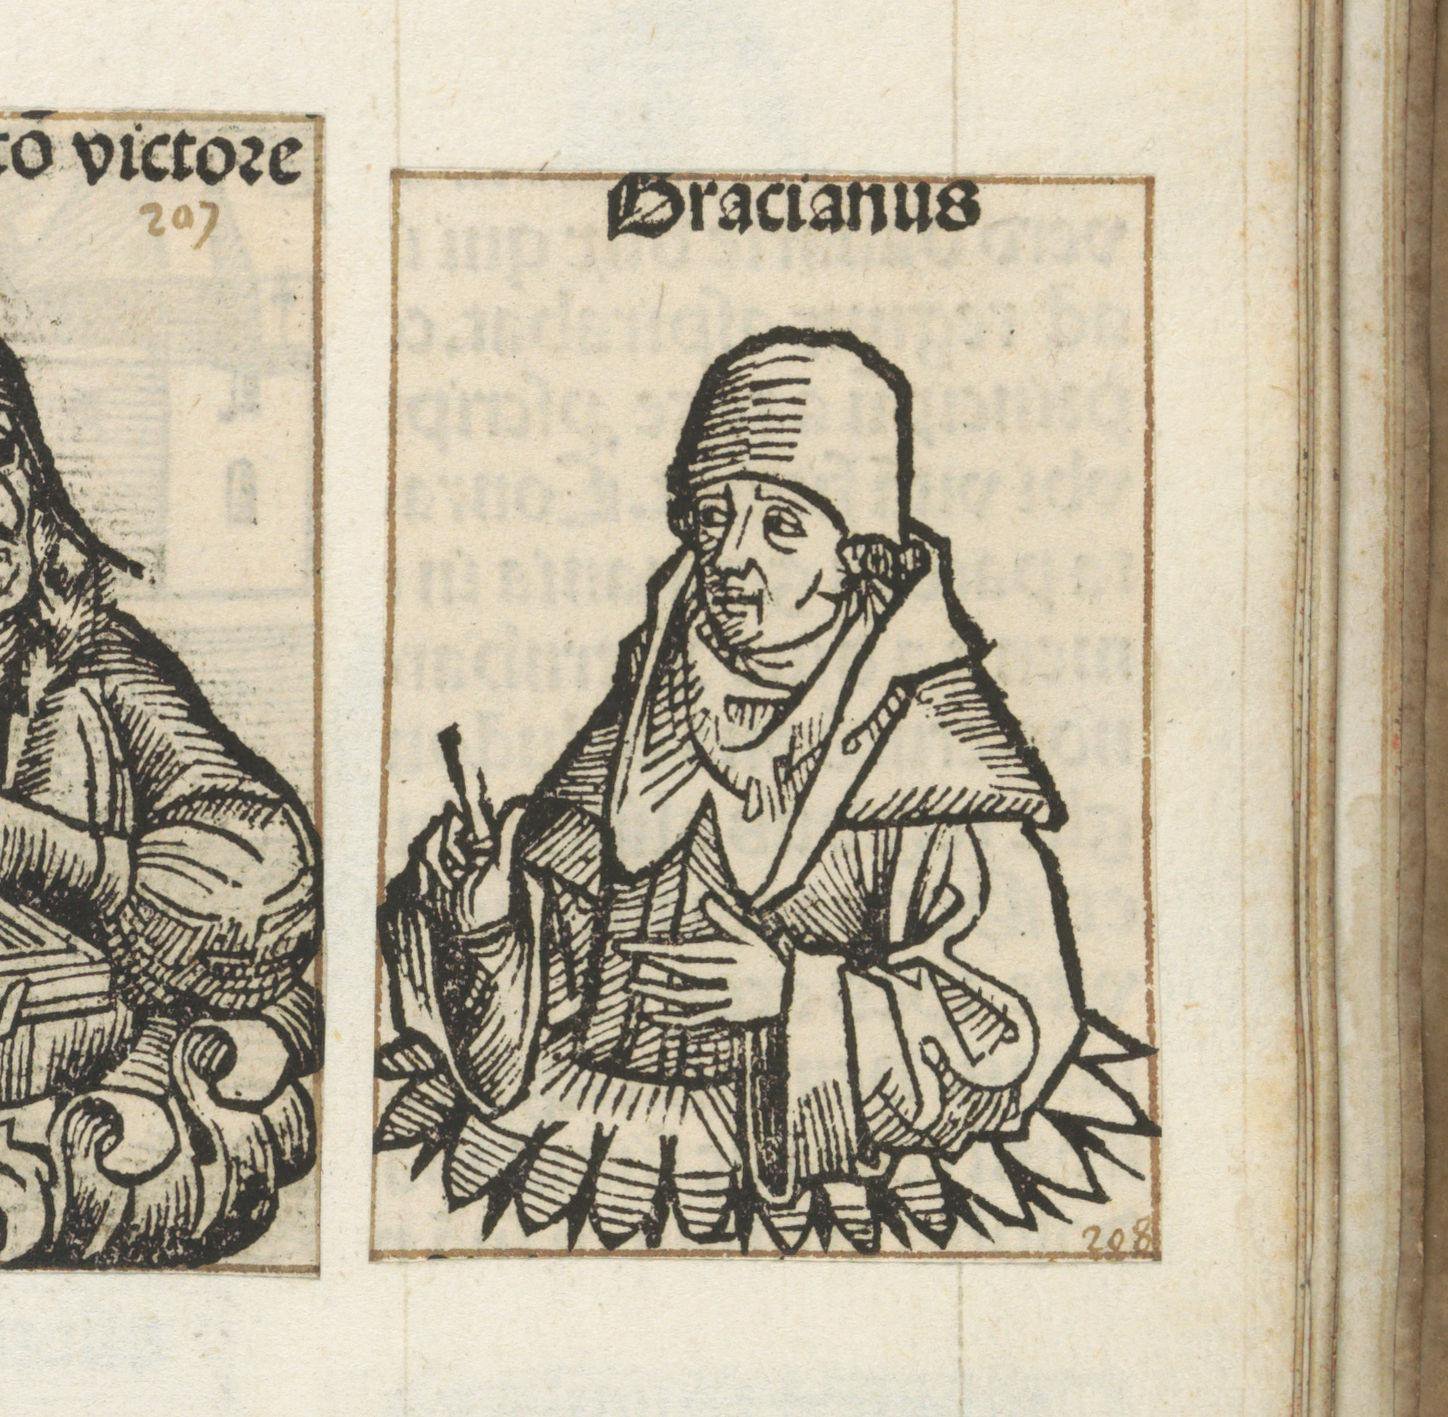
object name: album leaf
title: Gratianus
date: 1493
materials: paper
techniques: letterpress printing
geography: nuremberg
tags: monk(s), friar(s)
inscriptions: inscription: ‘208’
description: De houtsnede wordt herhaaldelijk gebruikt als boekillustratie in de Liber Chronicarum (of Neurenbergkroniek) van Hartmann Schedel, verschenen in het Latijn en Duits in 1493. Zie de Latijnse uitgave, folio 201v.